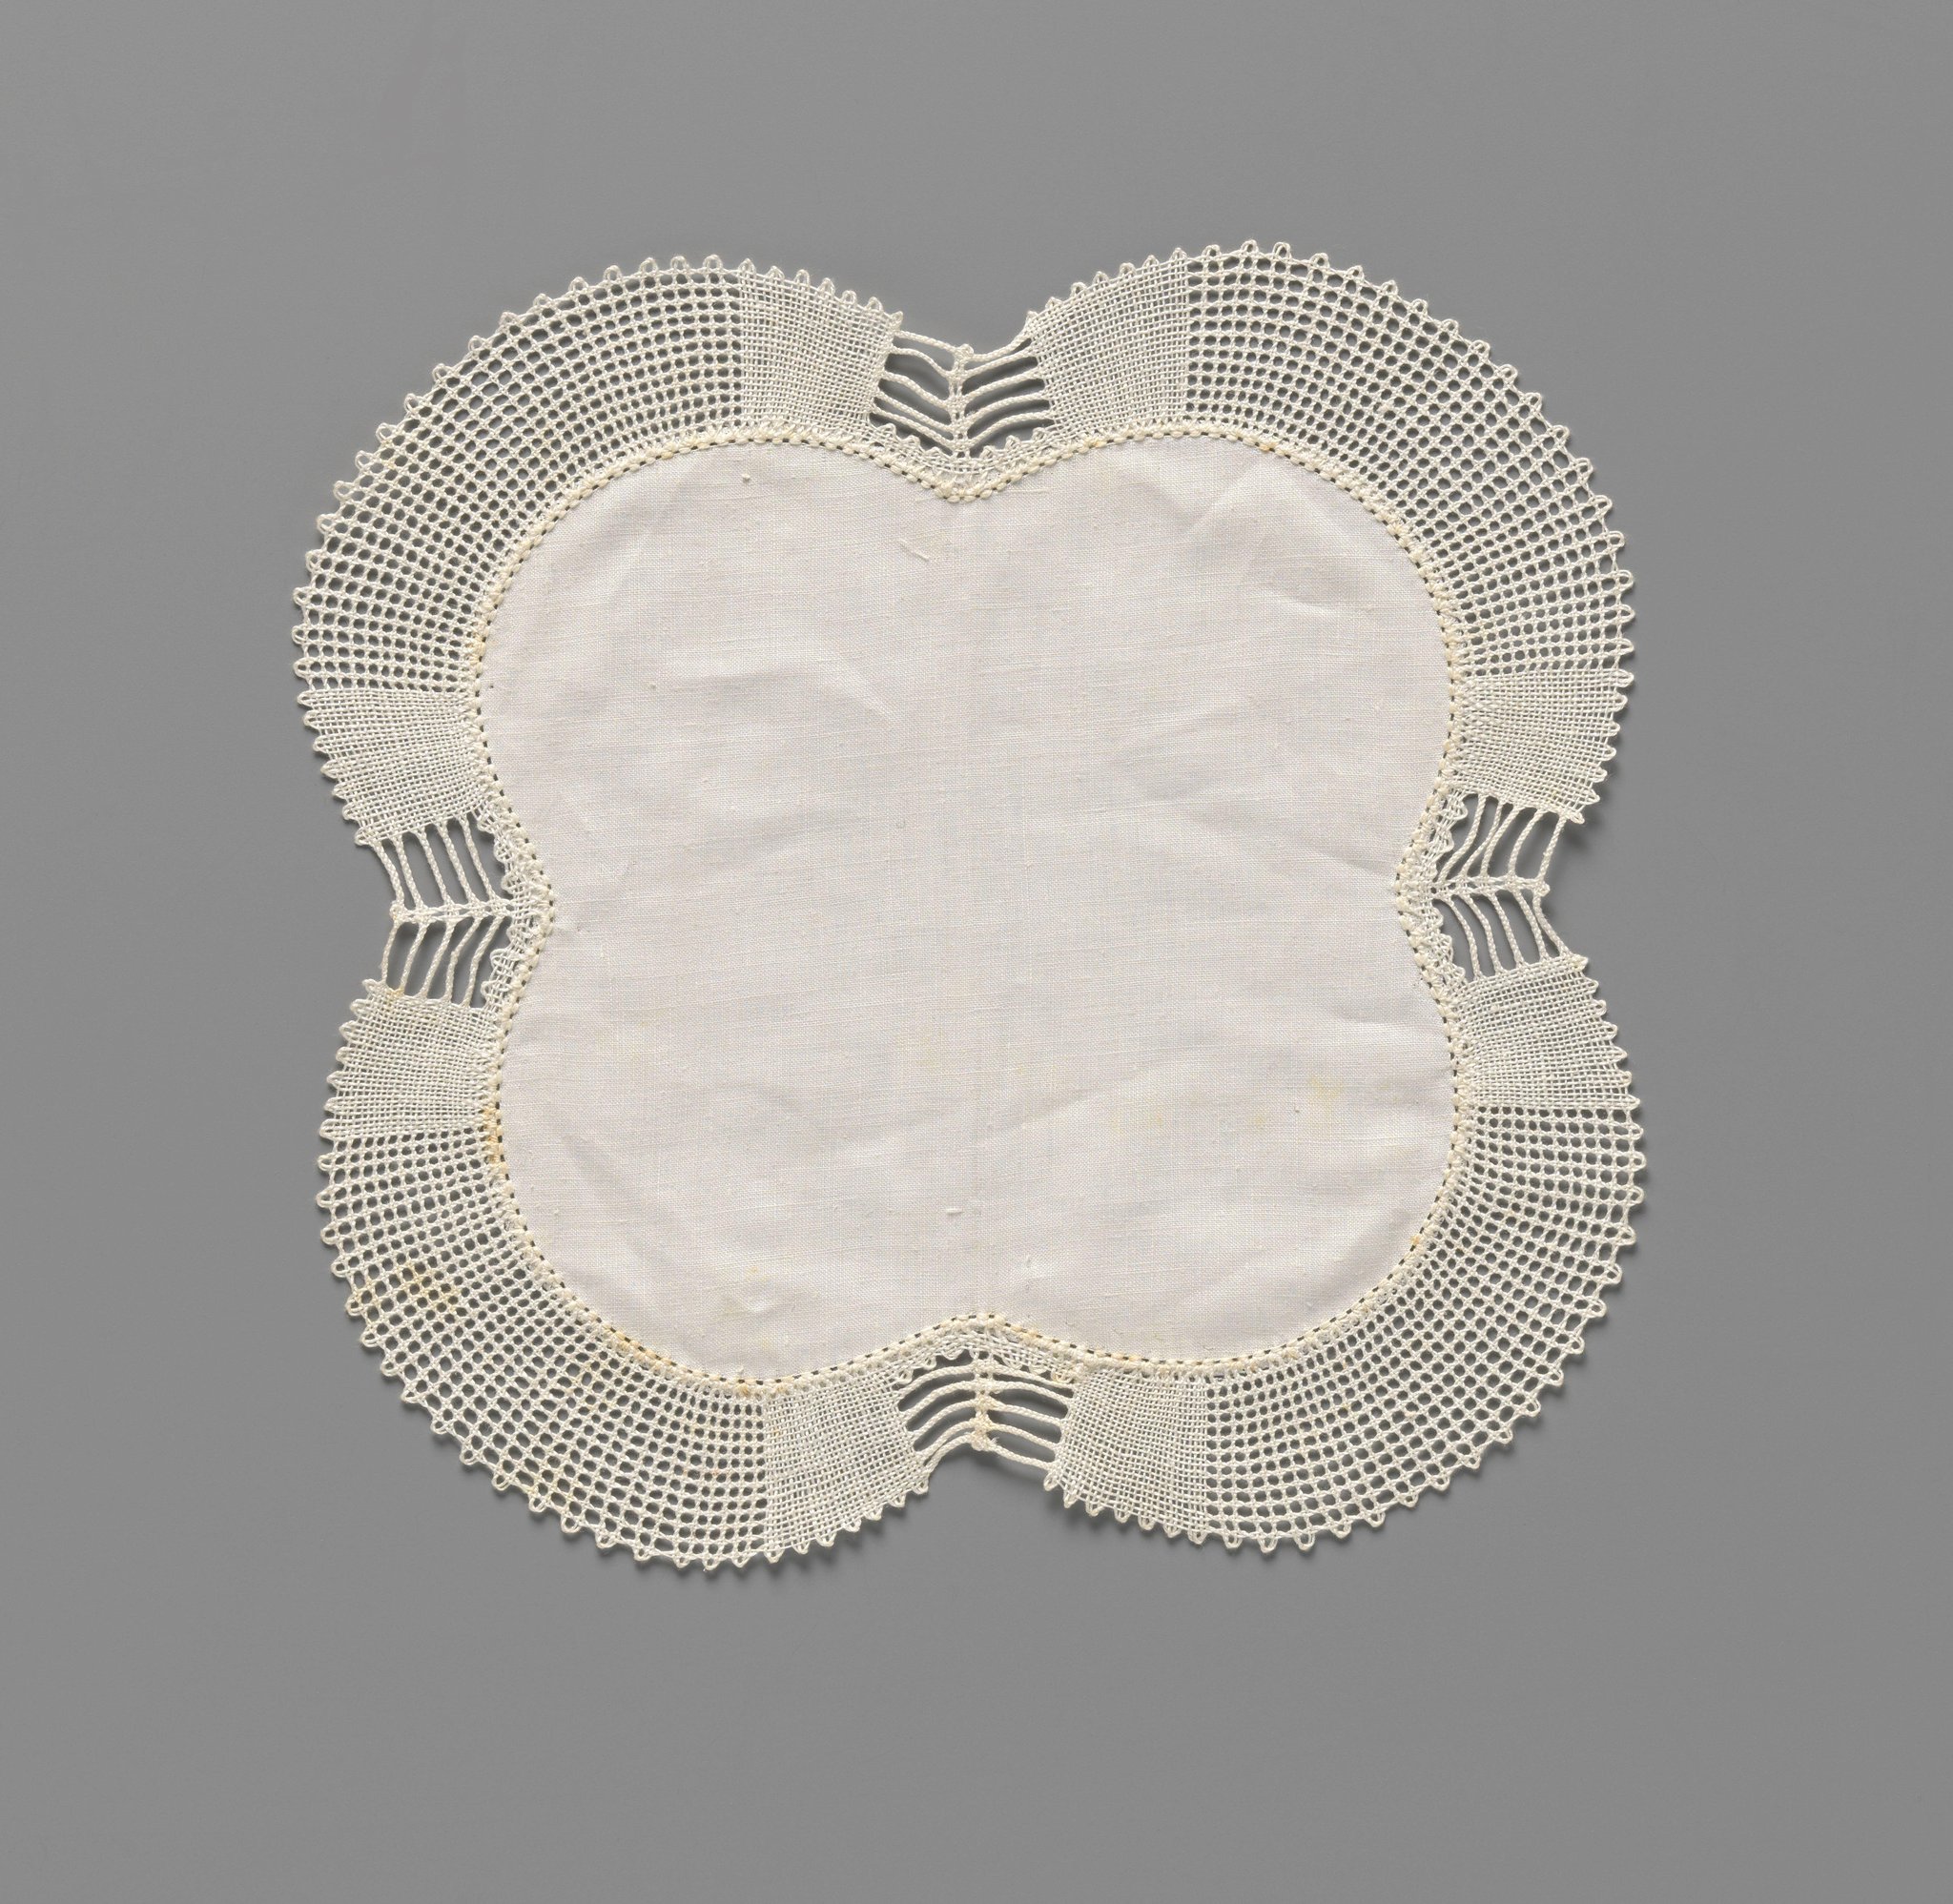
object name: kleed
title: Doily van linnen rozetvormig met vier lobben en rondom een rand kloskant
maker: Anonymous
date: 1925-1949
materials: linen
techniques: lace, weave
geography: netherlands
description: Doily van naturelkleurig linnen met rondom een rand kloskant: Nederlandse kant. Vierkant rozetvormig model met vier halfcirkelvormige schulpen of lobben. De rand kloskant volgt dit model.